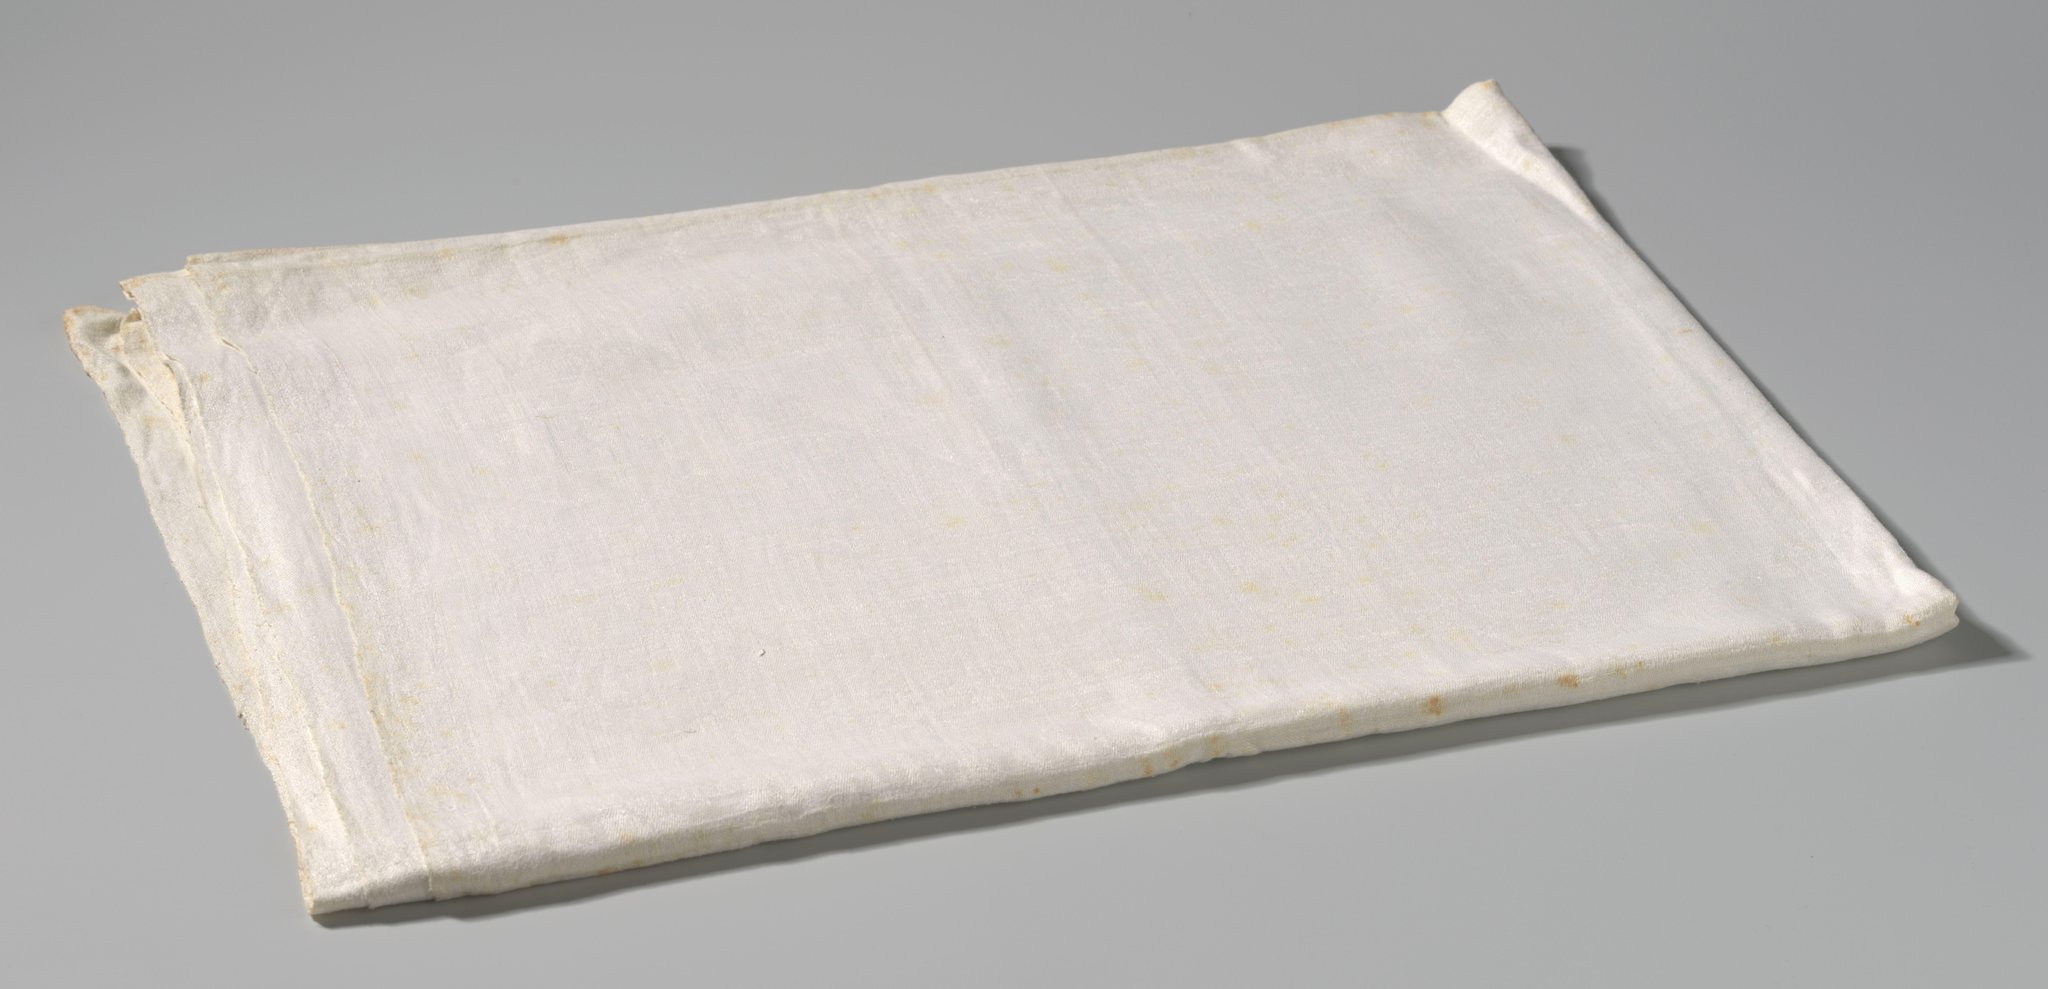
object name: tablecloth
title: Verheerlijking van Karel van Habsburg-Oostenrijk als Karel III van Spanje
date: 1706-1708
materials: linen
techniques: damask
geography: flanders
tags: vienna, charles vi (holy roman emperor)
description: Wit linnen damasten tafellaken met de verheerlijking van Karel van Habsburg-Oostenrijk als Karel III van Spanje, na de slag bij Ramillies, de verovering van Oostende en de verovering van Meenen. Merk J A W.